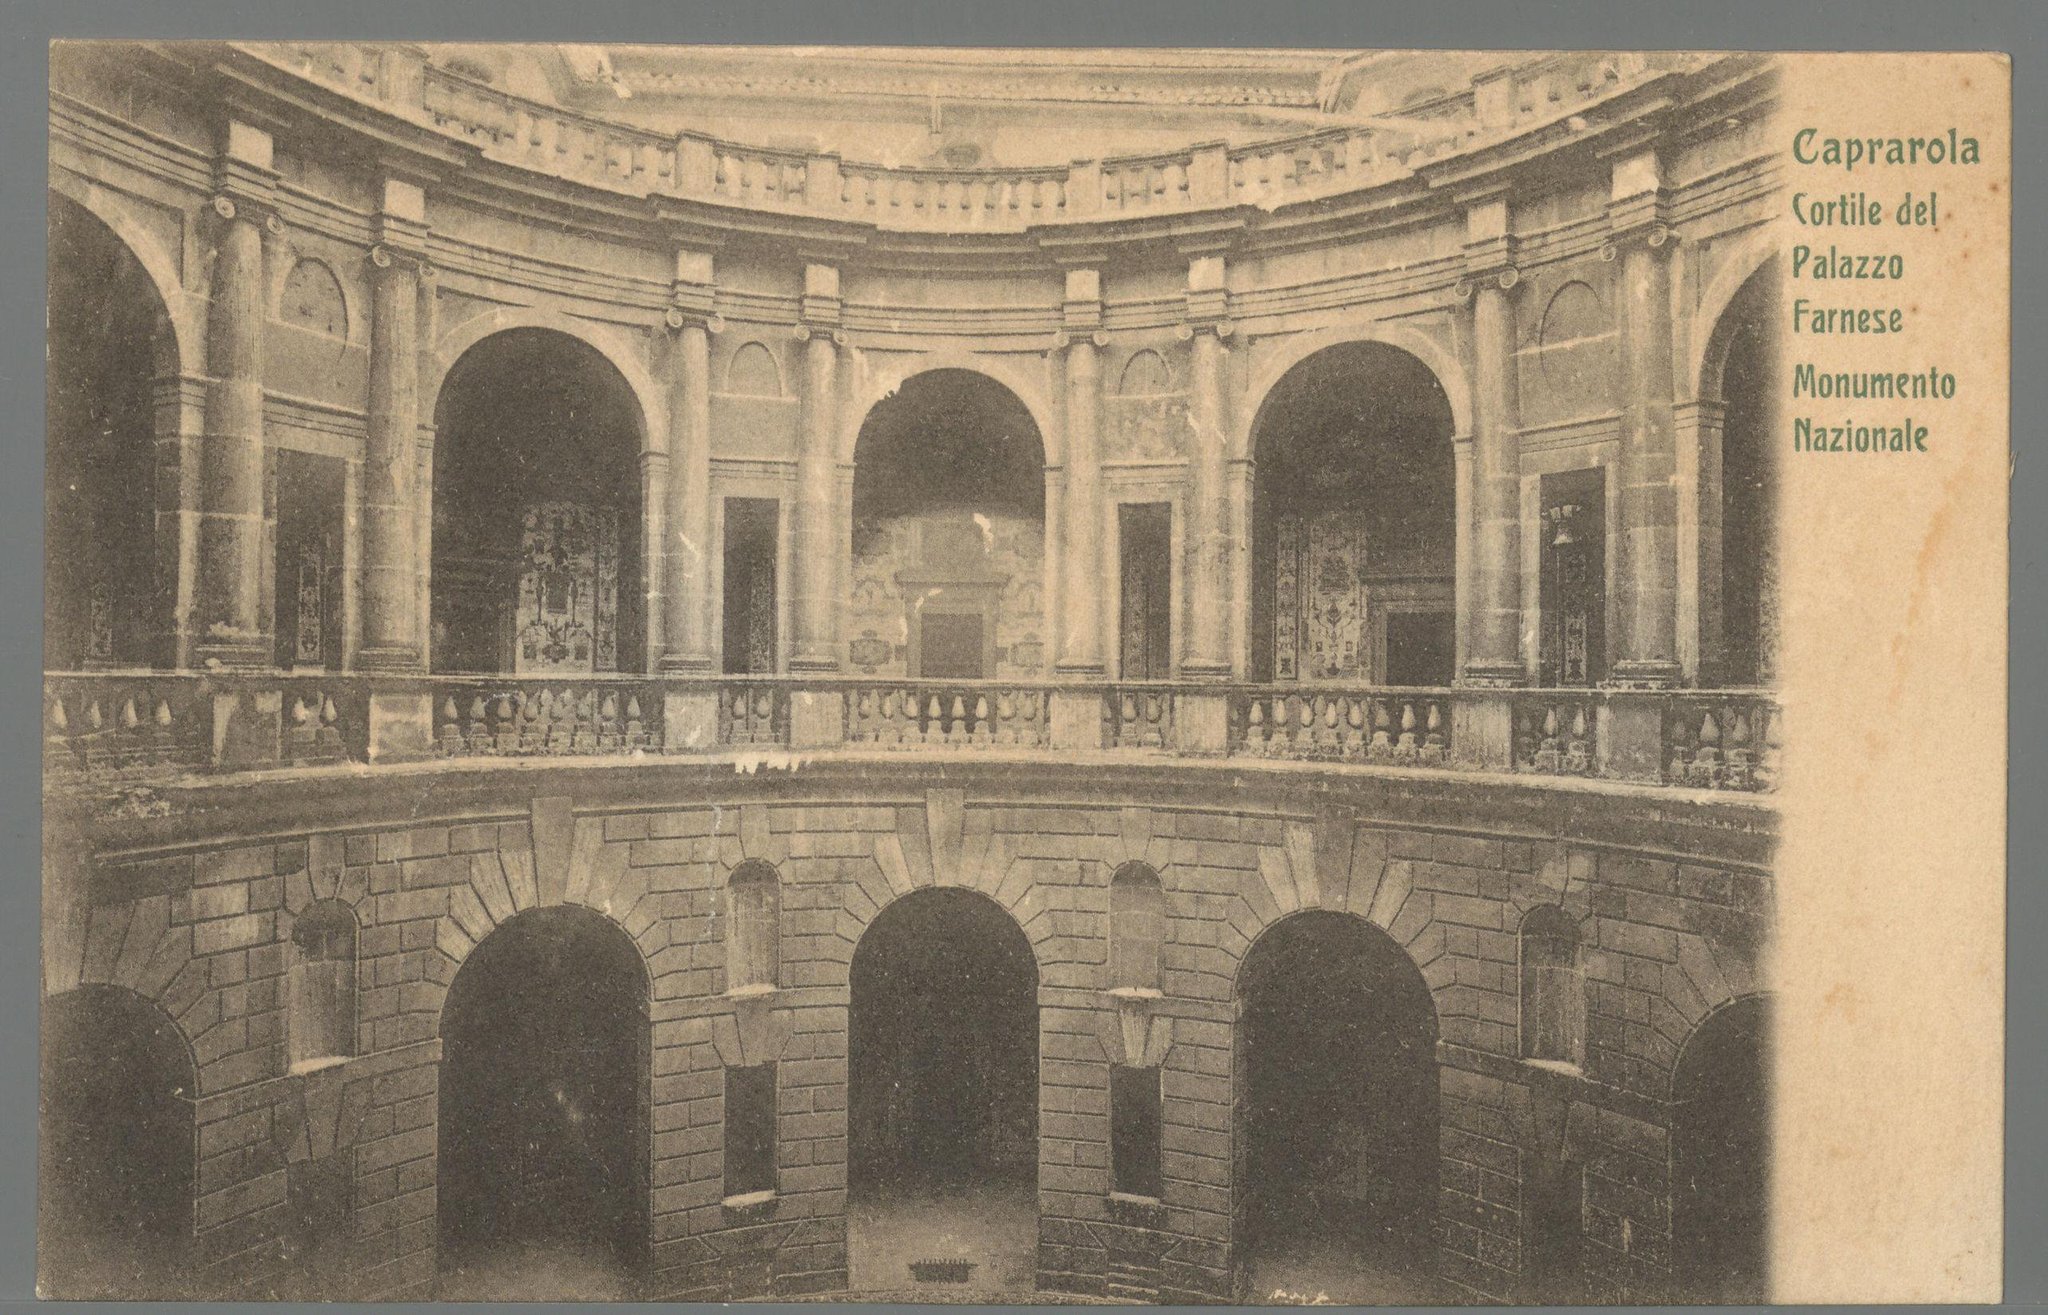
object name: photomechanical print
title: Caprarola. Cortile del Palazzo Farnese. Monumento Nazionale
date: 1906-1930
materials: cardboard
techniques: photograph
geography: viterbo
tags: palace, interior ~ representation of a building